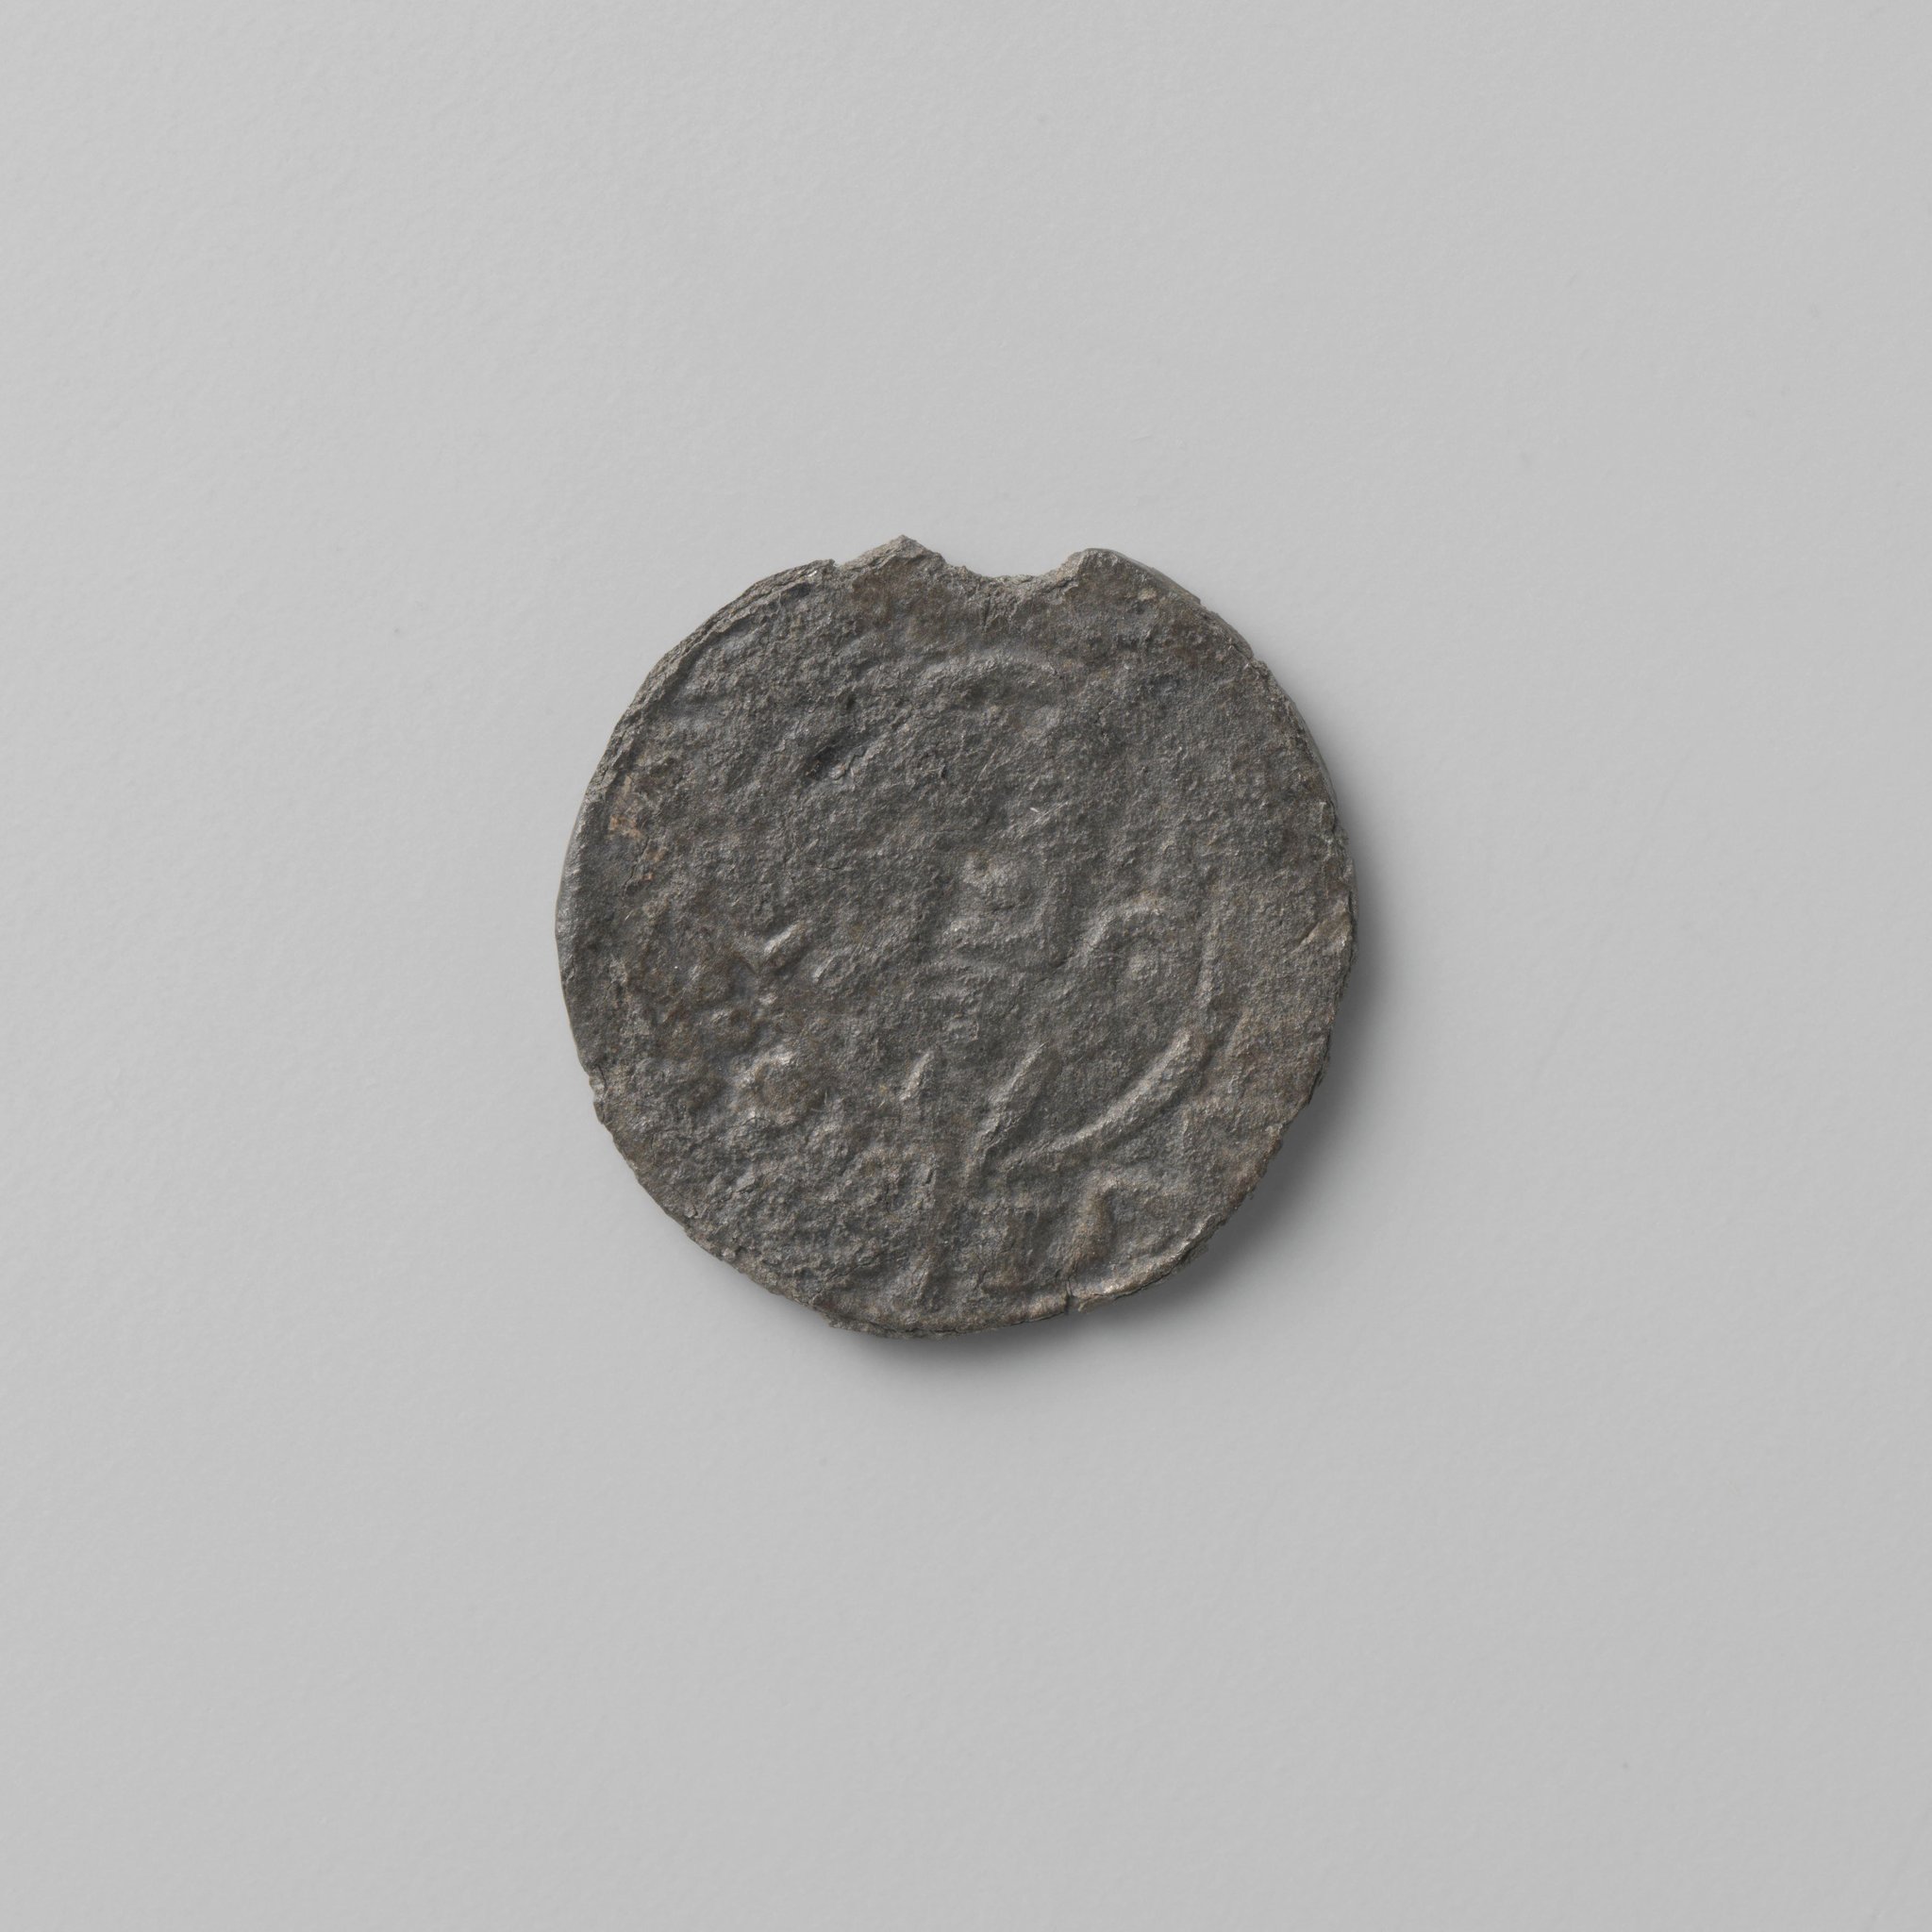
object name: coin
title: Utrecht, Boudewijn van Holland, penning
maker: baldwin ii of holland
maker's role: bisschop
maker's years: 1141-1196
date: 1178-1196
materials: silver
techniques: striking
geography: utrecht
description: Zilveren munt. Voorzijde: portret van de bisschop met muts naar rechts met voor zich bisschopsstaf. Omschrift. Keerzijde: kort kruis, in hoeken afwisselend sterretje en drietand. Omschrift.